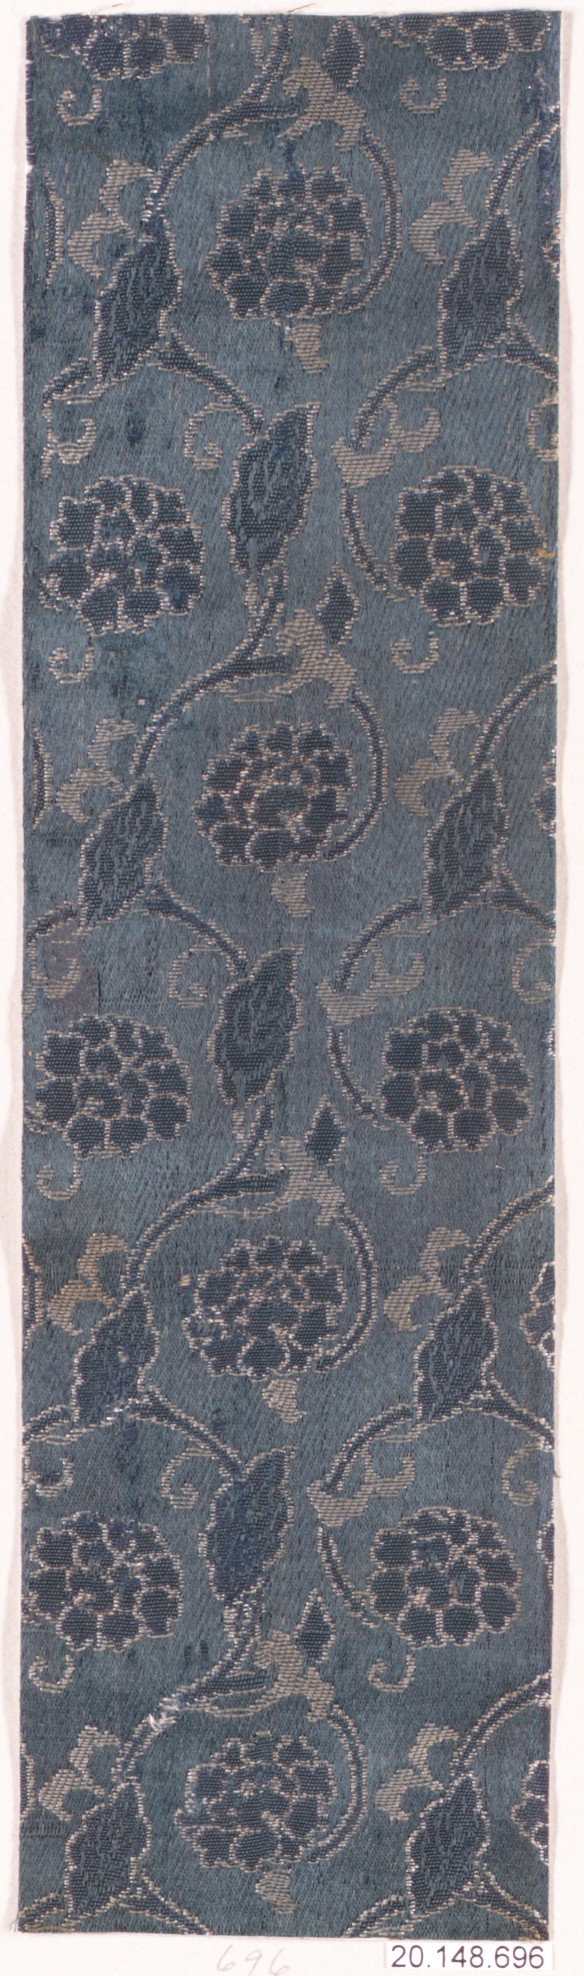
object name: piece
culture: japanese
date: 1601-1700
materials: silk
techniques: compound weave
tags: flowers,leaves